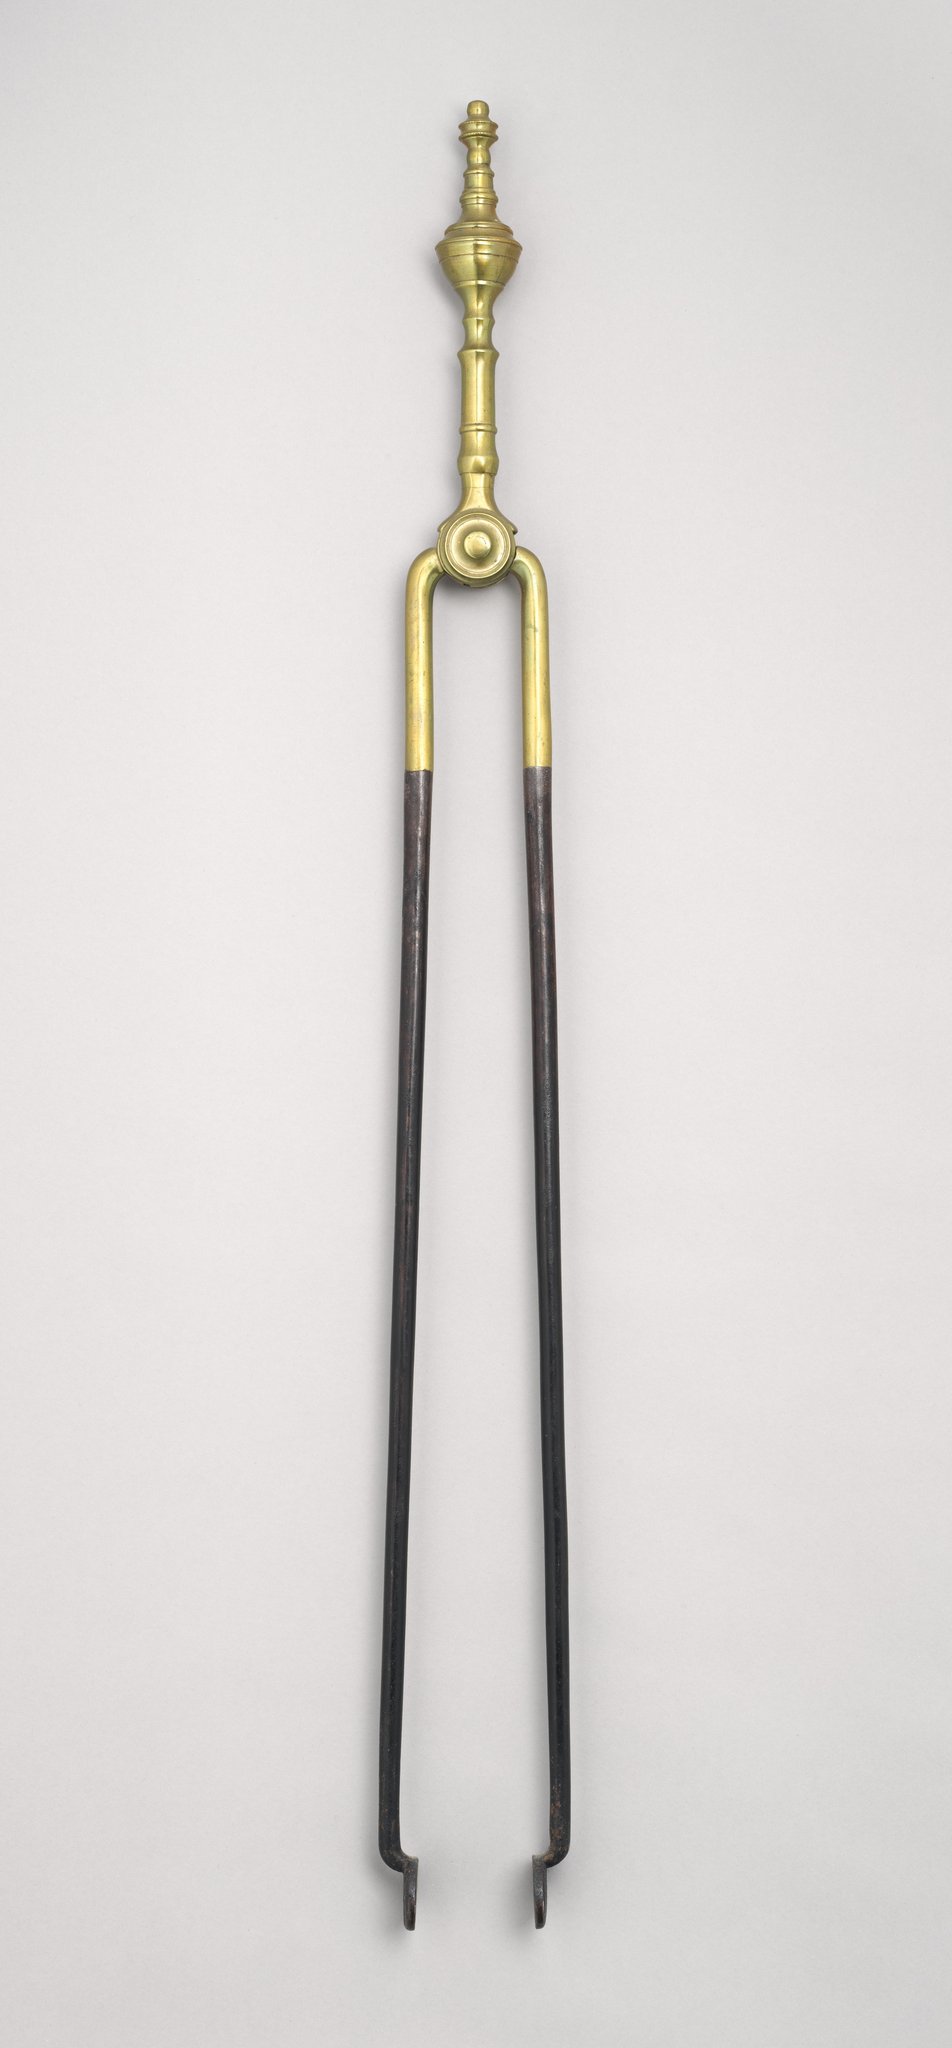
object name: tongs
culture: american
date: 1795-1815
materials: brass, iron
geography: united states